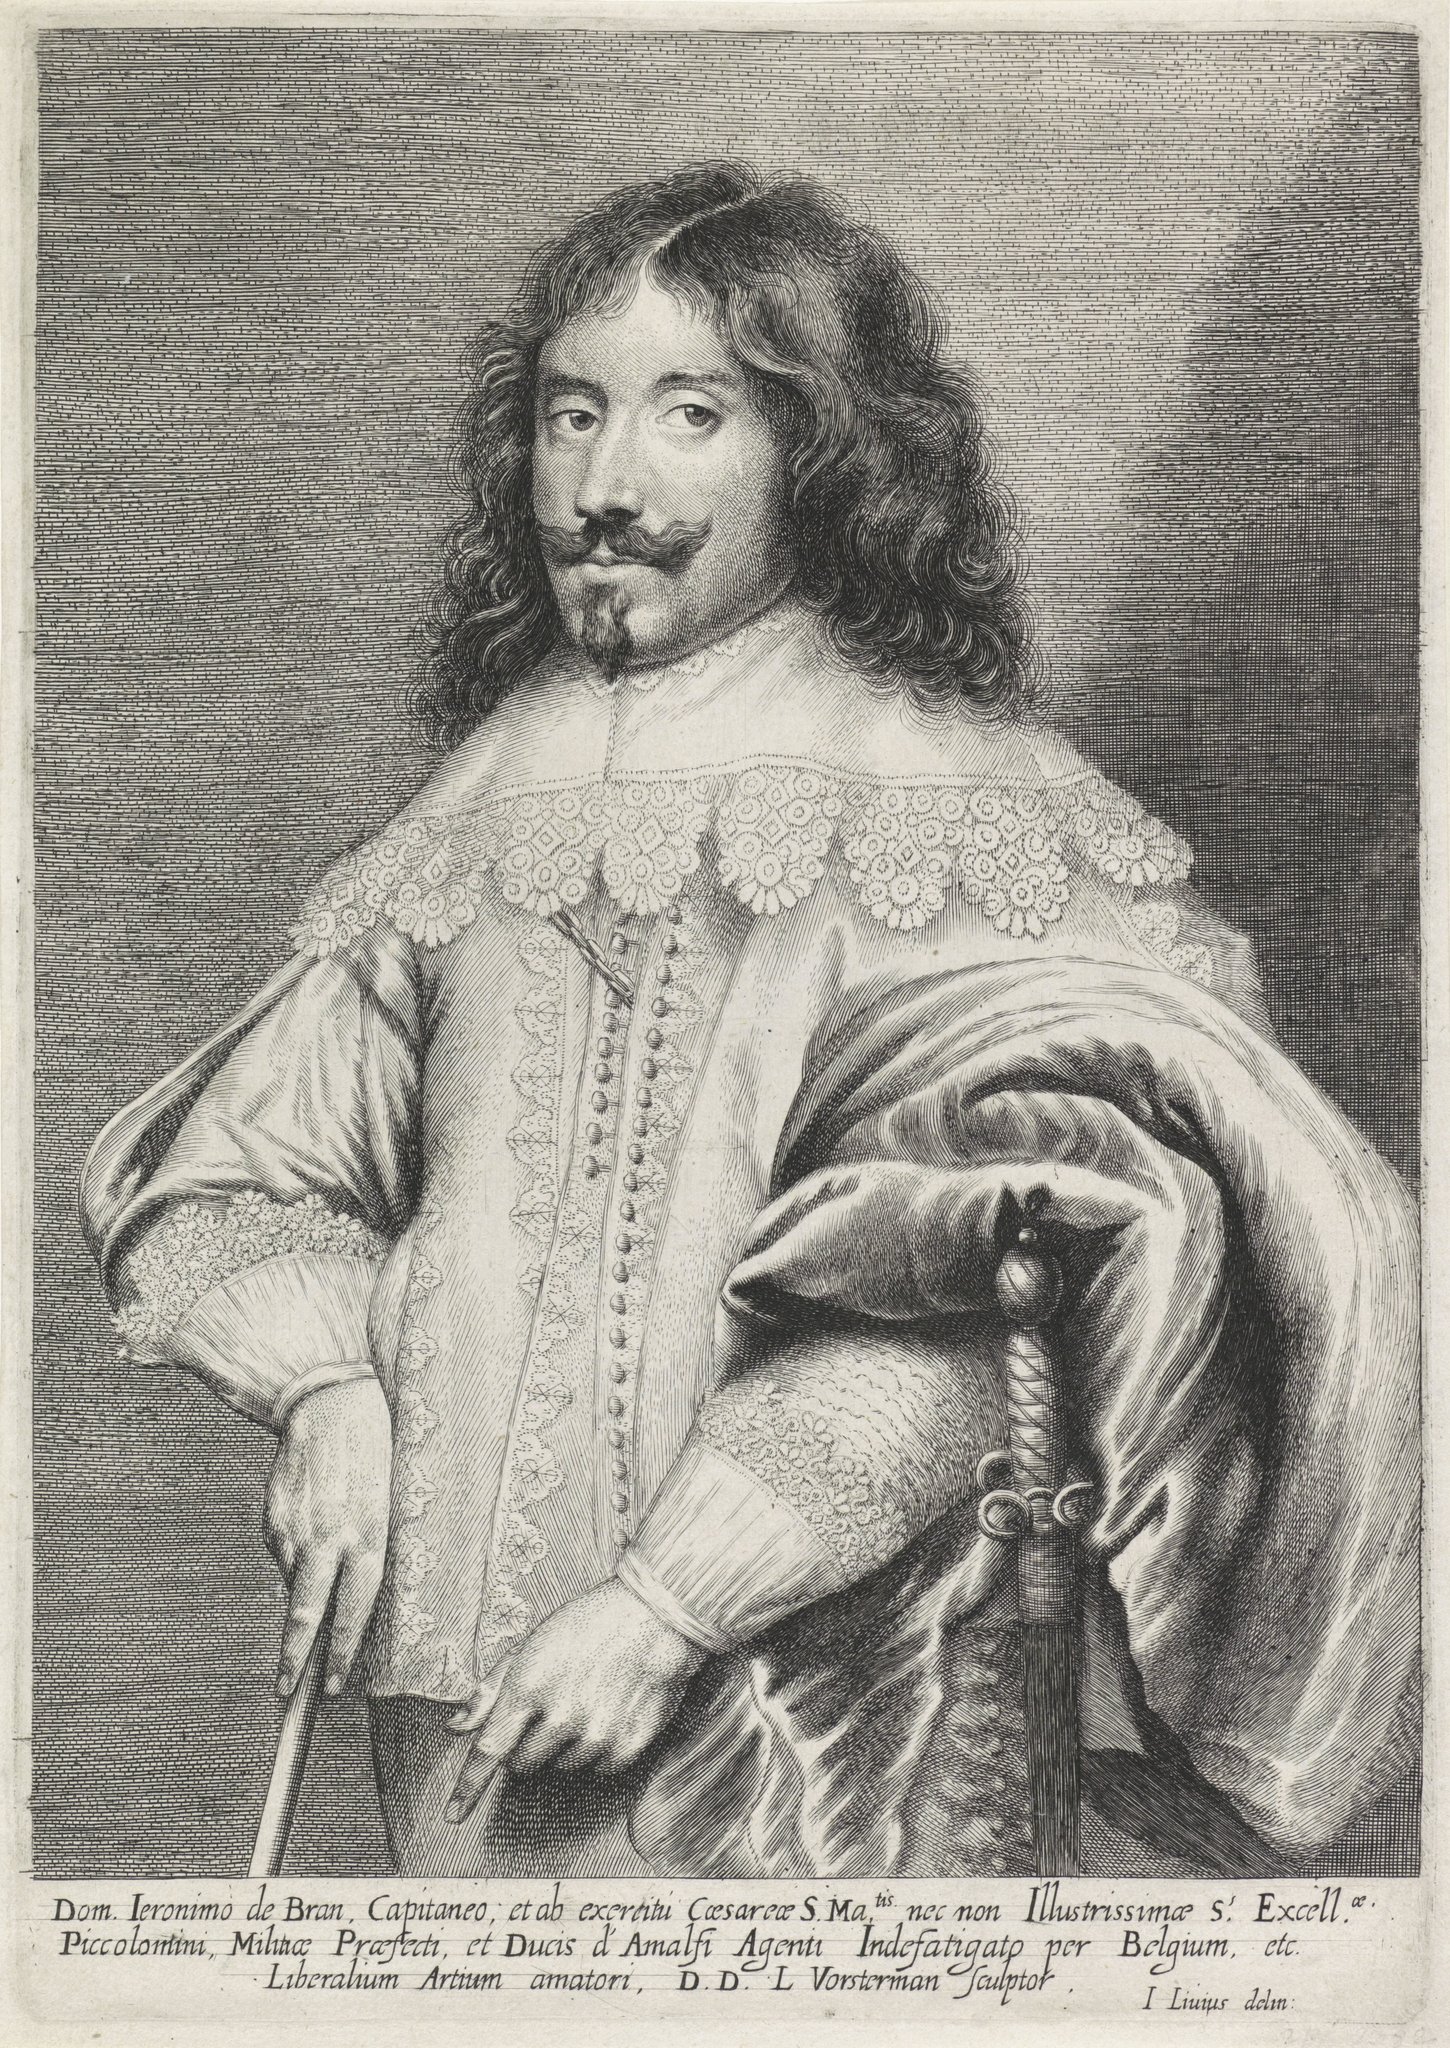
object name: print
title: Portret van Jeronimo de Bran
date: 1619-1675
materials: paper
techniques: engraving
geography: antwerp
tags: kapitein, jeronimo de bran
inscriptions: collector's mark: Lugt 240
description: Portret van Jeronimo de Bran, kapitein in dienst van de koning van Spanje in Duitsland, Engeland en de Nederlanden.